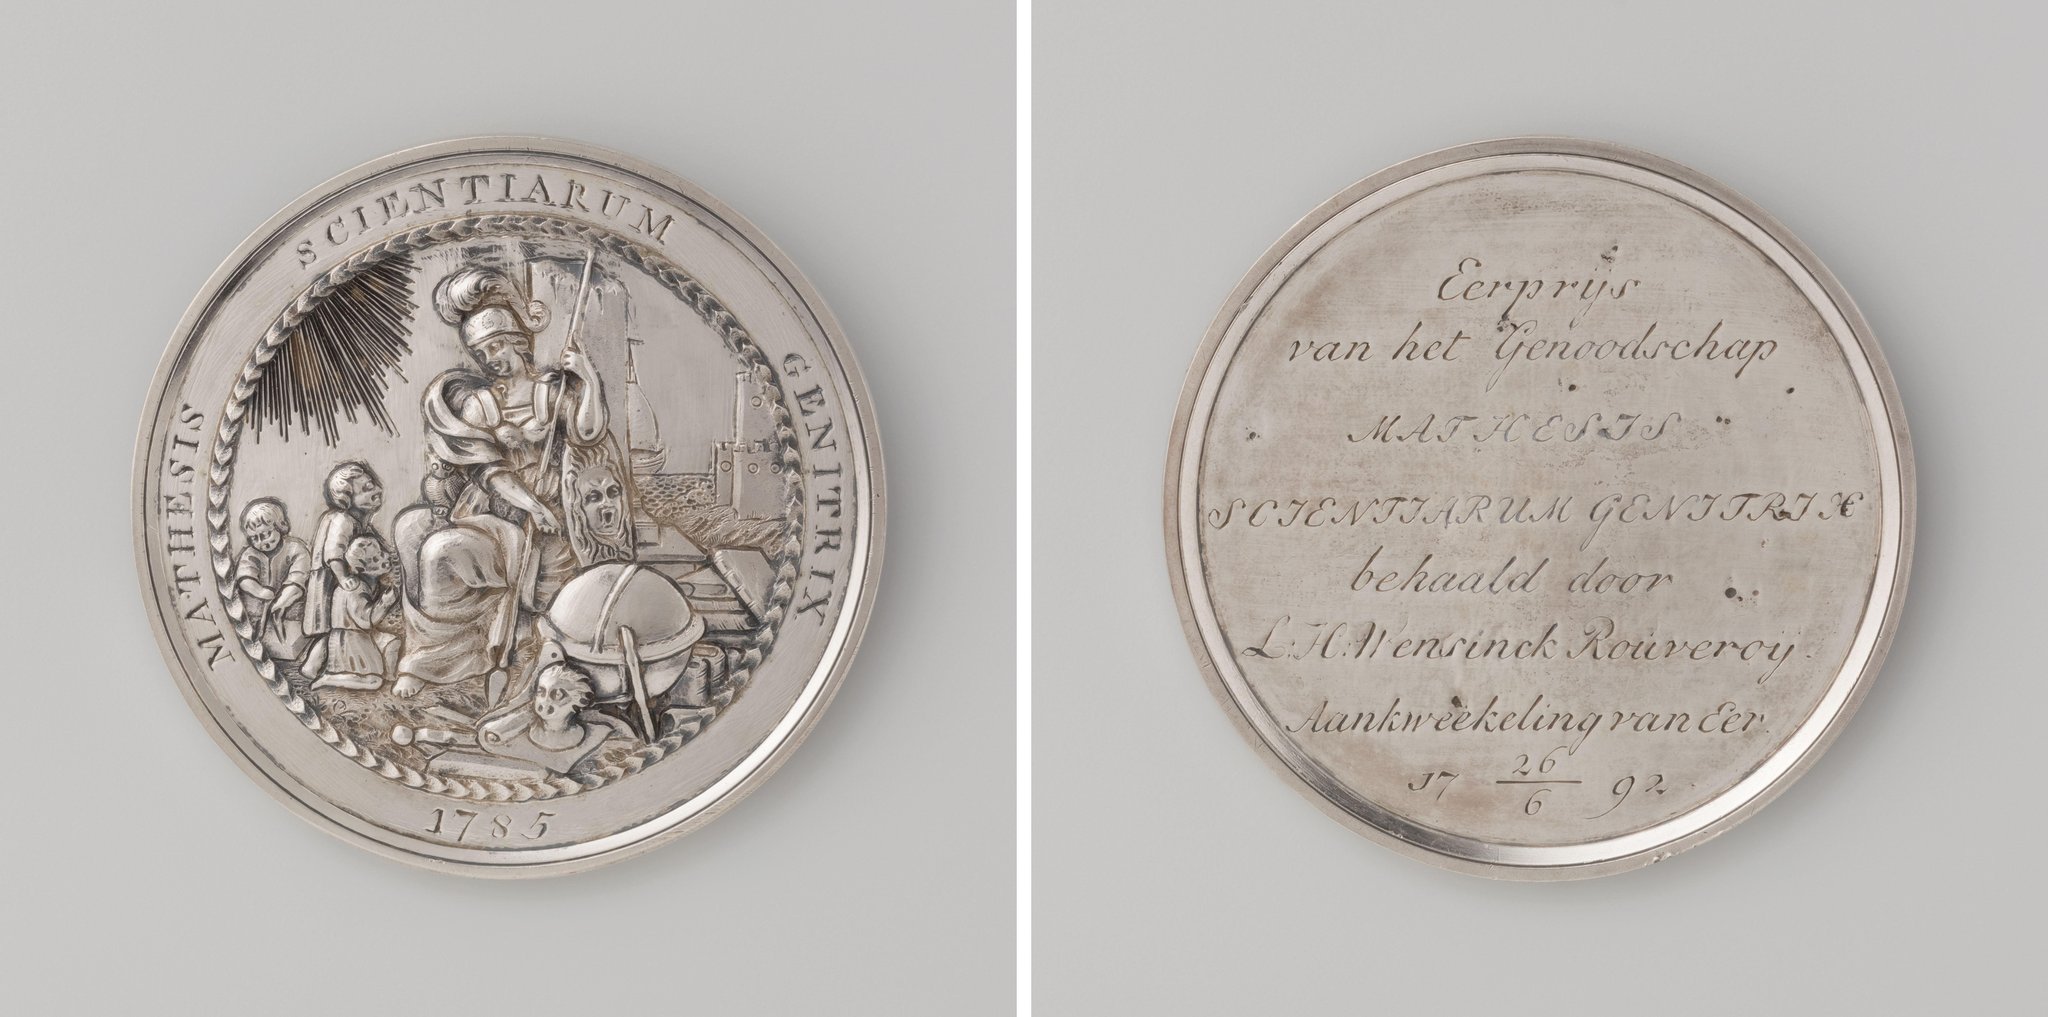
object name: medal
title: Genootschap "Mathesis Scientiarum Genitrix", penning toegekend aan L.H. Wensinck Rouveroy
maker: Anonymous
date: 1792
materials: silver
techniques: casting, engraving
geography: netherlands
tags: leiden